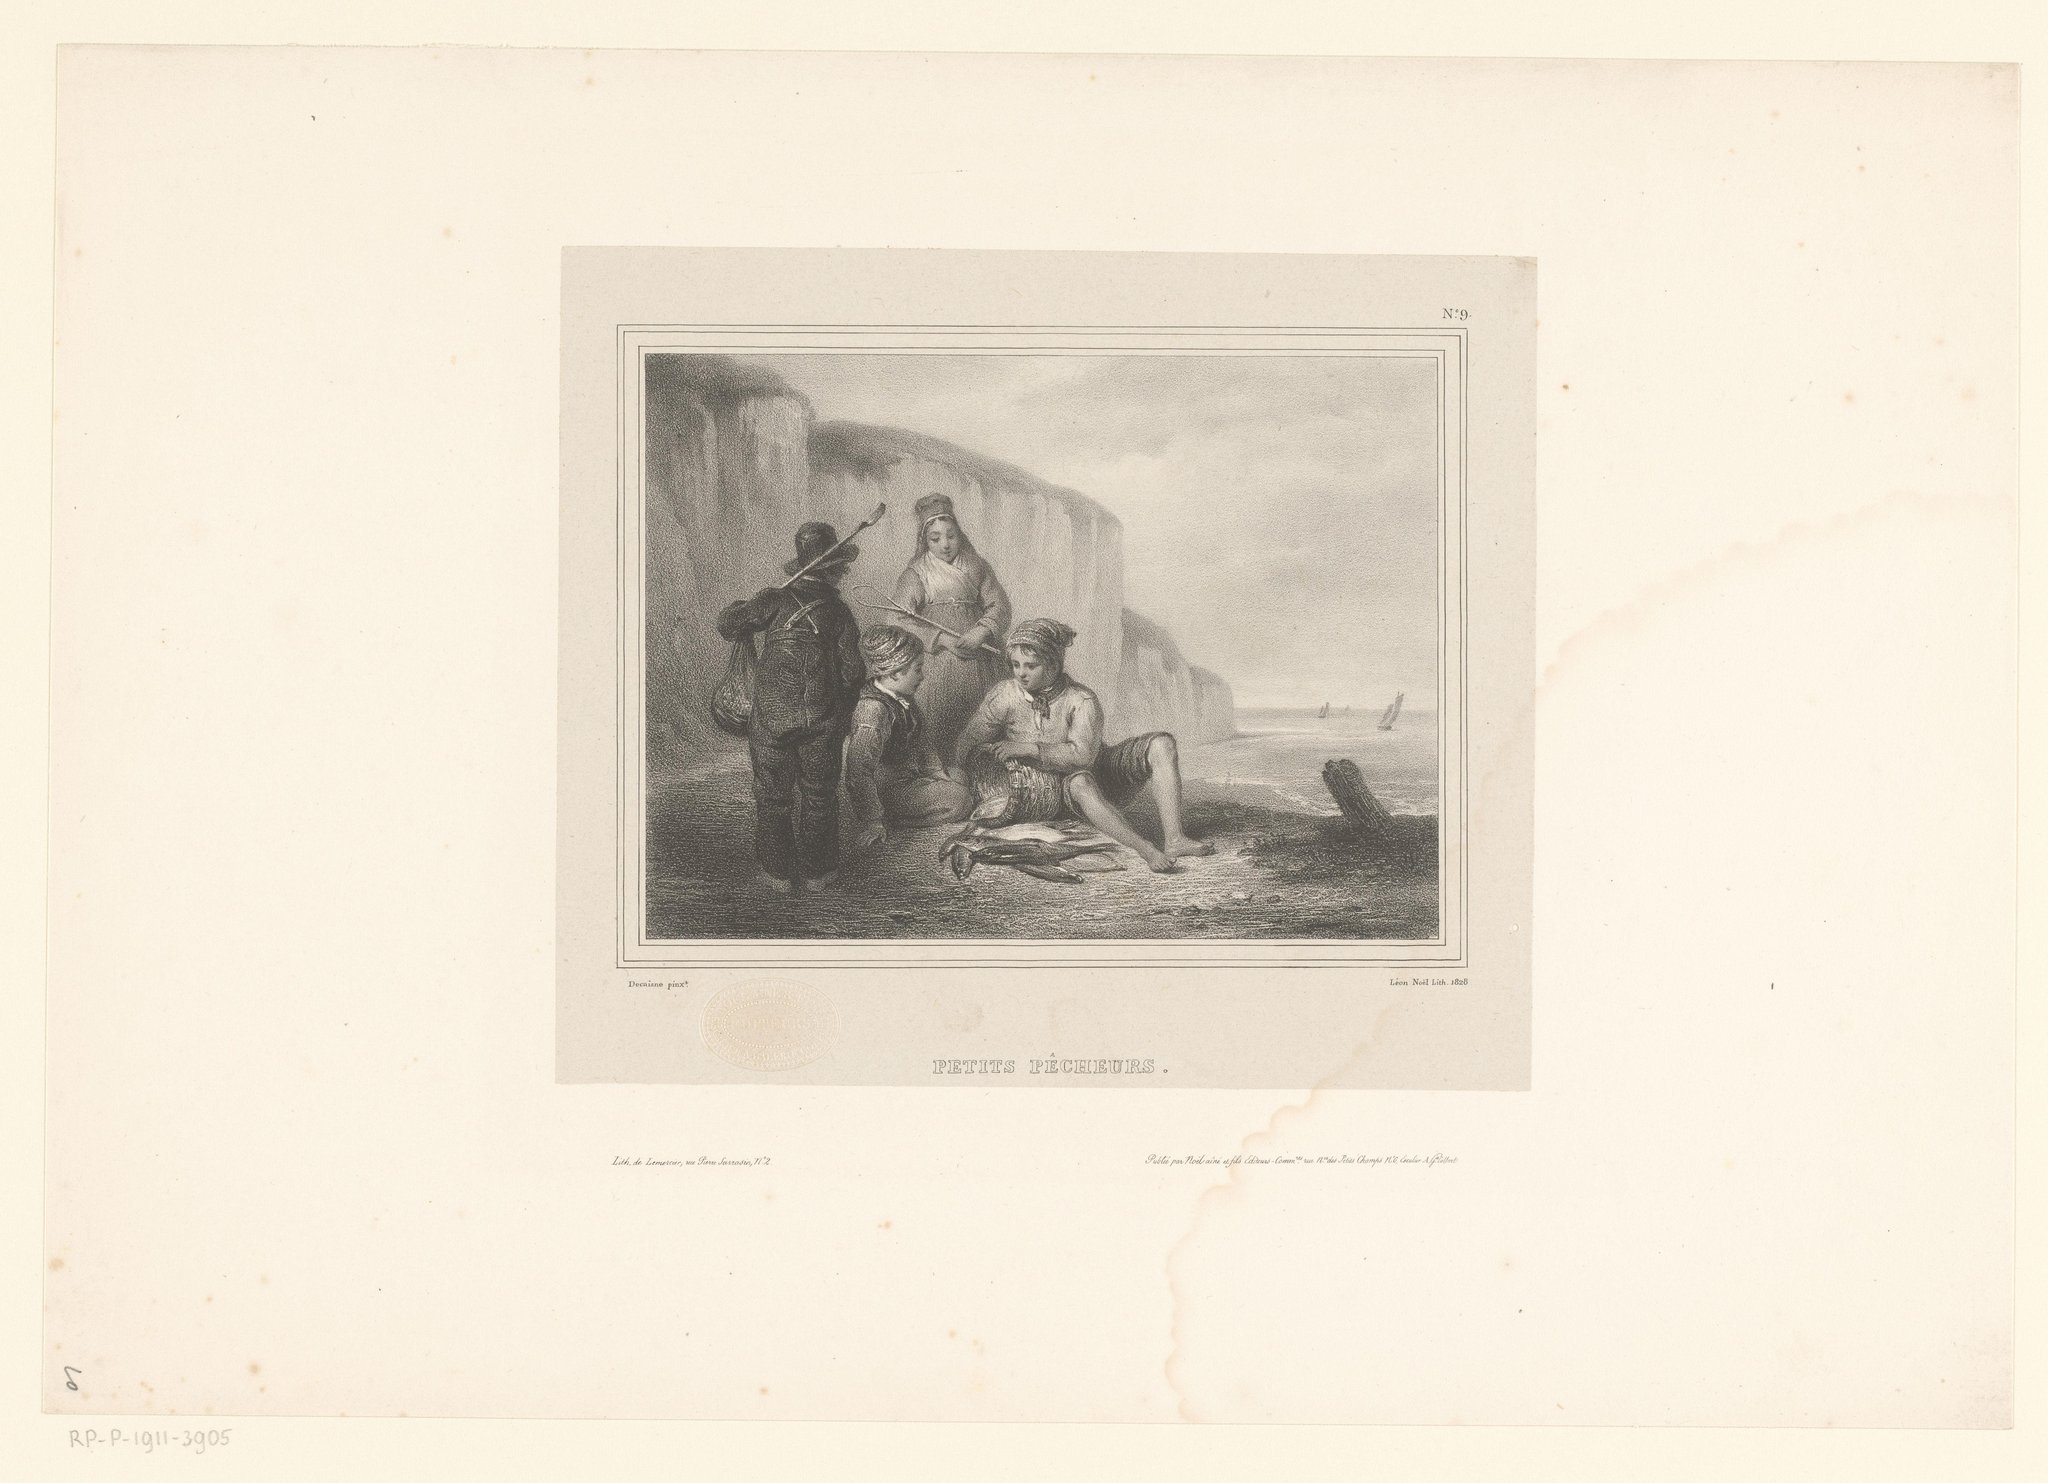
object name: print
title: Petits pêcheurs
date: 1828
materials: paper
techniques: lithograph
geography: paris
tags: children's games and plays, fishing (sports), beach, sea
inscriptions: check stamp: Lugt 4944, collector's mark: Lugt 2228